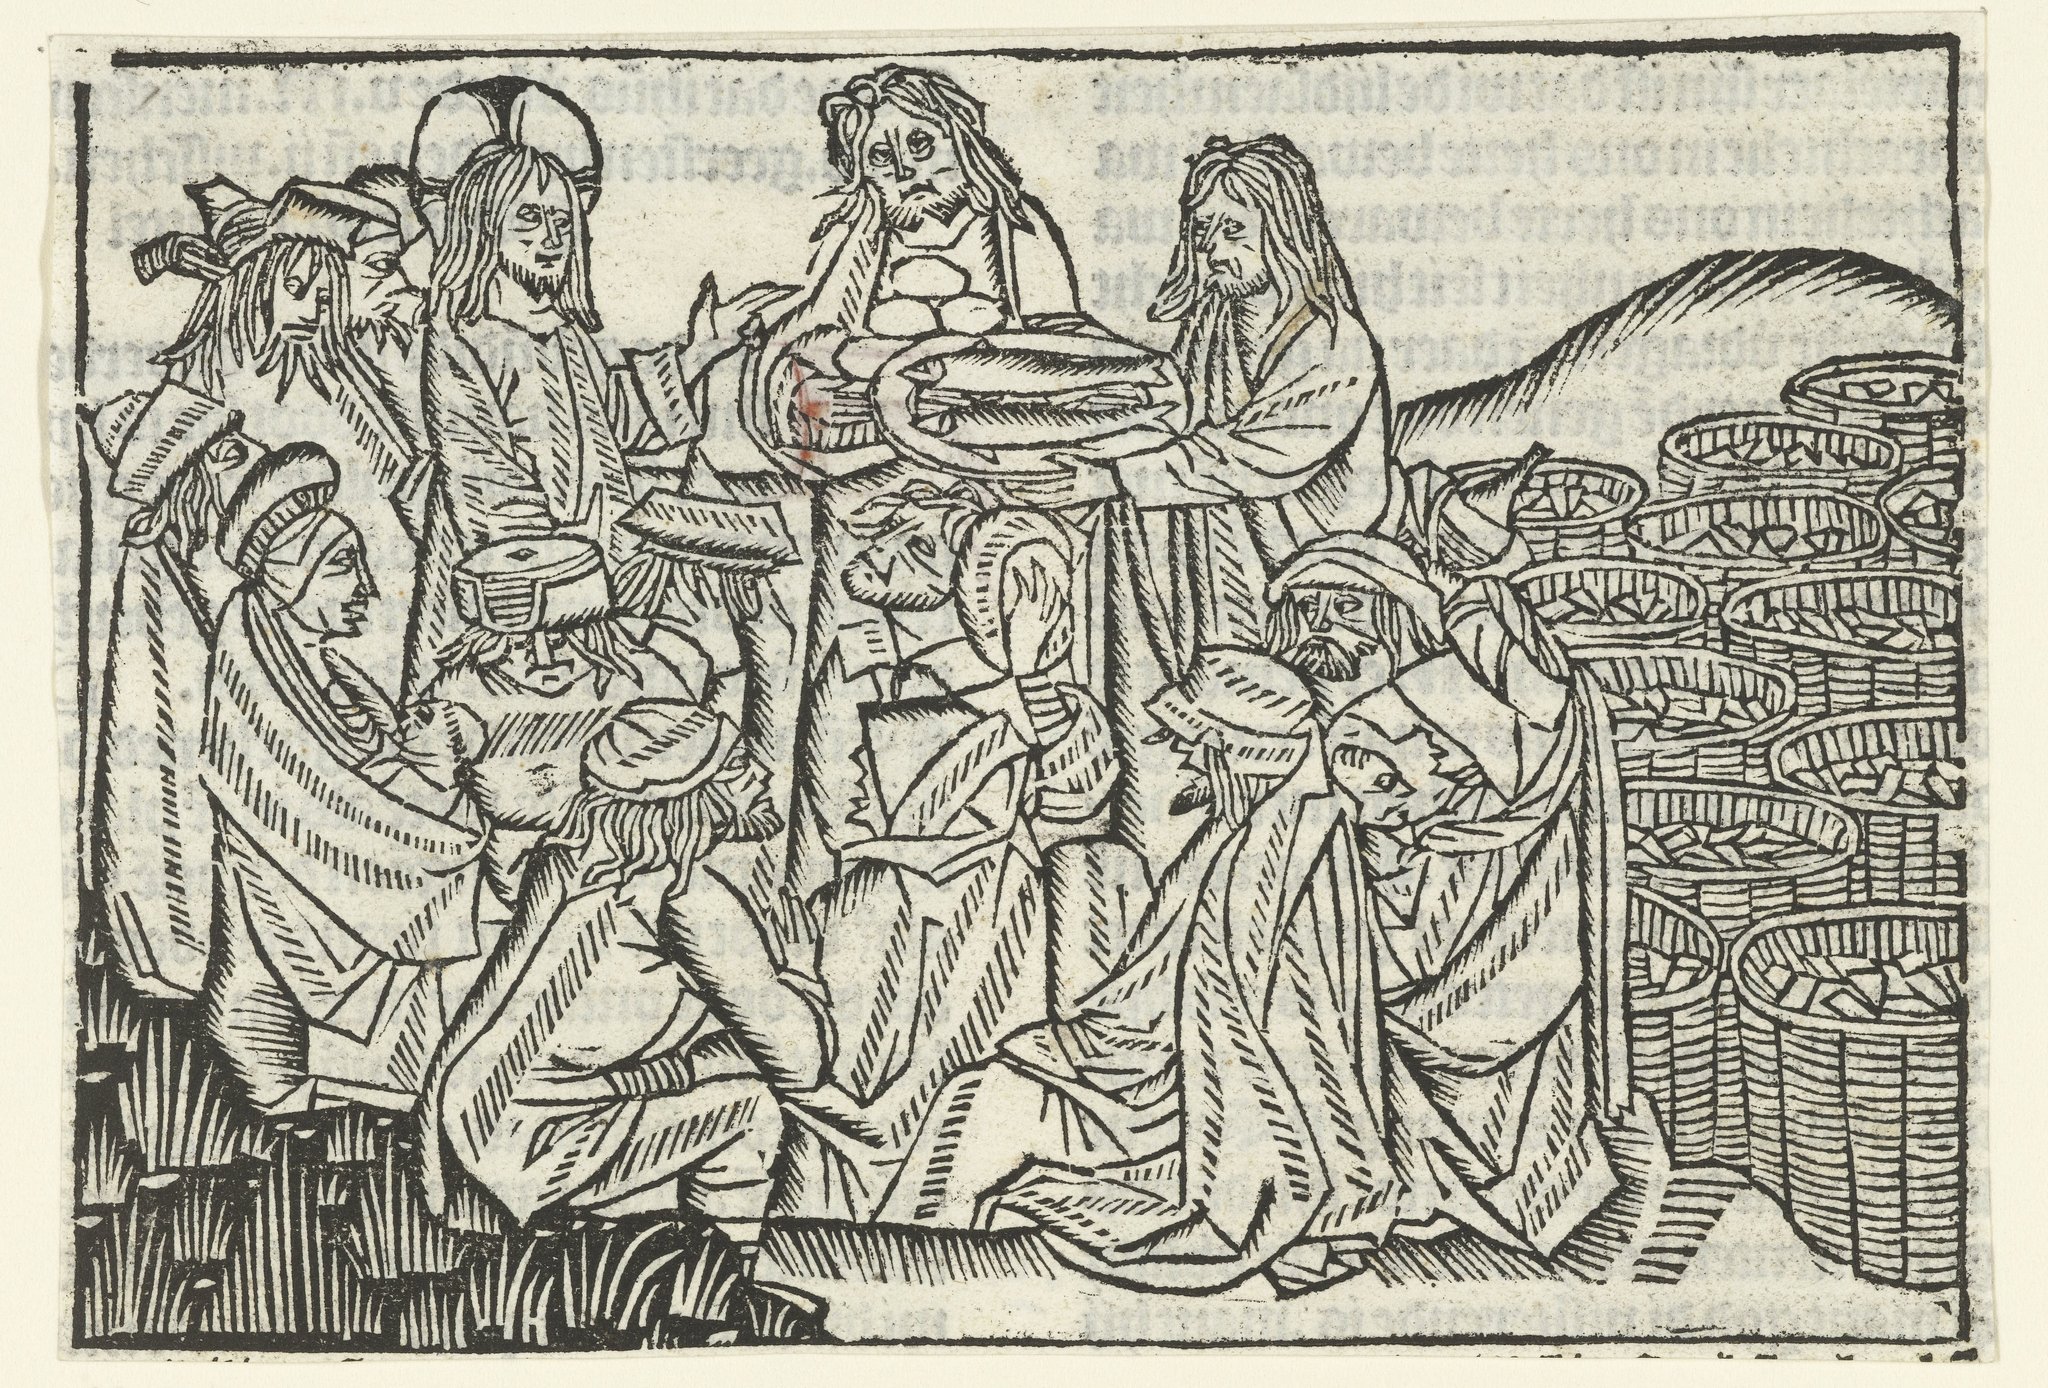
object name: book illustration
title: Het voeden van de vijfduizend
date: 1480-1500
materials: paper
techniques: woodcut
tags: multiplication of loaves and fishes for a multitude of four or five thousand people (matthew 14:13-21, 15:32-39; mark 6:32-44, 8:1-10; luke 9:10-17; john 6:1-14)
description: Eén blad van 113 uit Ludolphus de Saxonia, "Dit es dleué ons liefs heeren ihesu christi". Anonieme Nederlandse vertaling. Uitgegeven door Henrick Eckert van Homberch te Antwerpen in 1503. Botke, K. Deze 113 houtsneden, die meestal reeds in vroege Nederlandse boeken gebruikt zijn, worden toegeschreven aan de tweede Meester van Delft, de Meester van de Delbecq-Schreiber-passie en de Meester van de Virgo inter Virgines. In Conway (1884) en in "De gulden passer"(1951) zijn ook eerdere versies opgenomen. Botke, K.